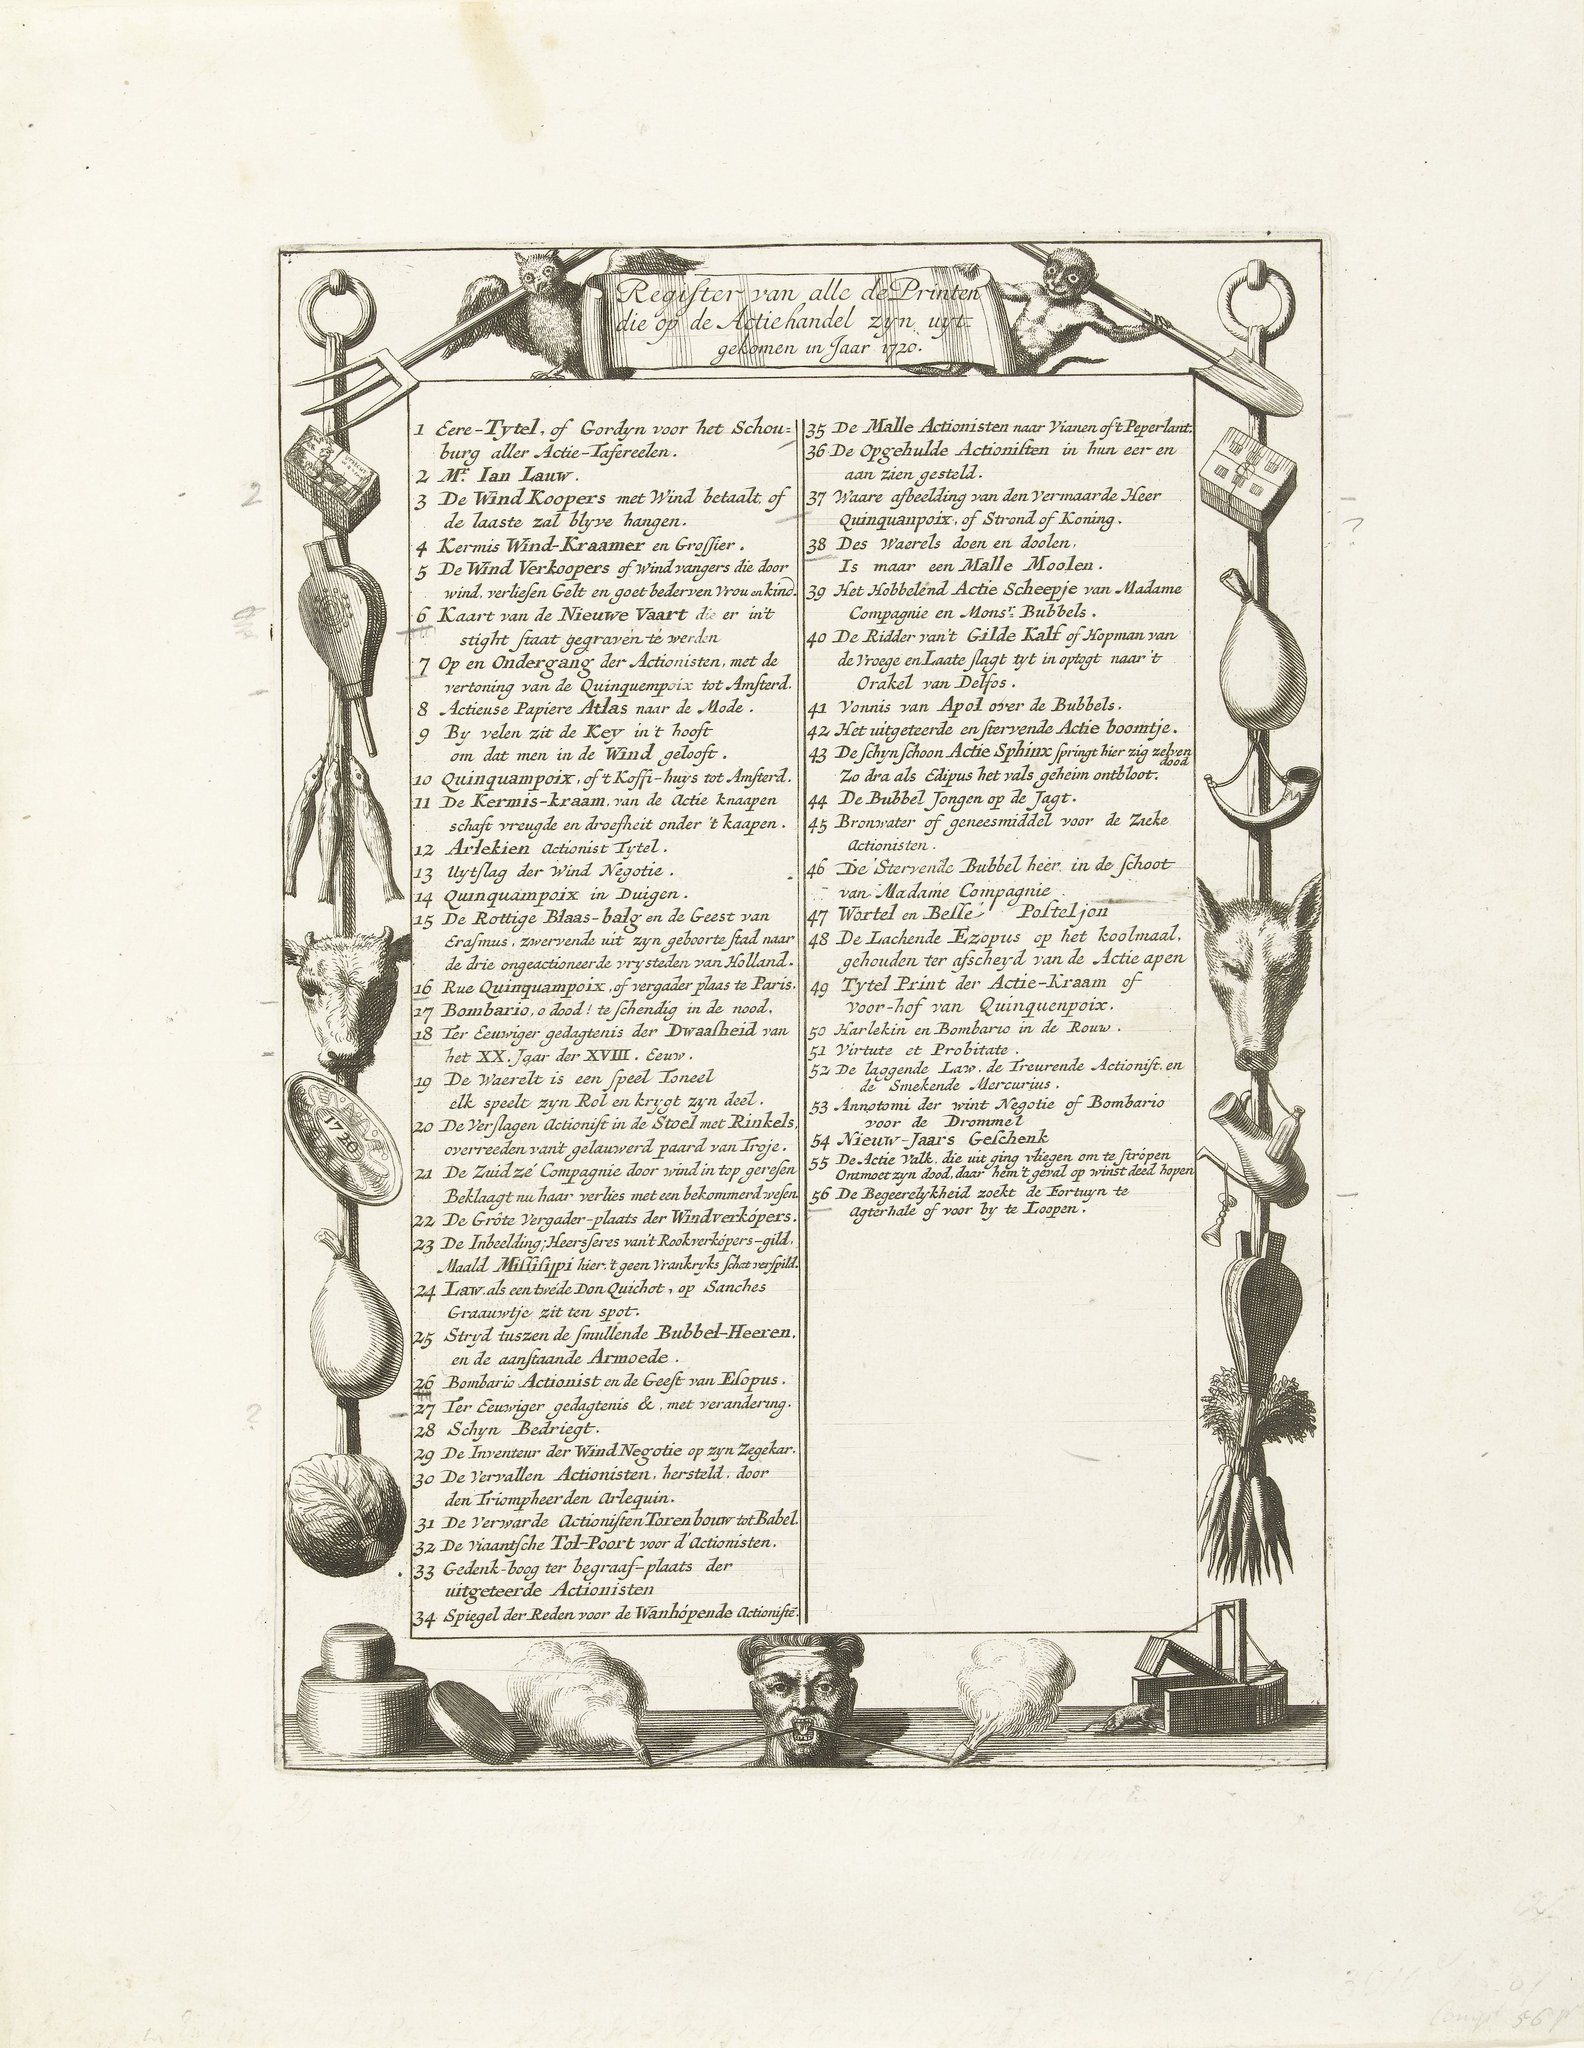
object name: cartoon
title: Register van de prenten in Het Groote Tafereel der Dwaasheid, 1720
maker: Anonymous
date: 1720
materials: paper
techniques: etching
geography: northern netherlands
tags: windhandel van 1720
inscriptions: collector's mark: Lugt 2228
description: Register van de prenten in Het Groote Tafereel der Dwaasheid. Lijst van prenten genummerd 1-56. In een omlijsting versierd met dierenkoppen, groenten, een roker met twee pijpen en allerlei voorwerpen. Register voor de serie Tafereel der Dwaasheid met spotprenten op de Windhandel of Actiehandel van 1720.